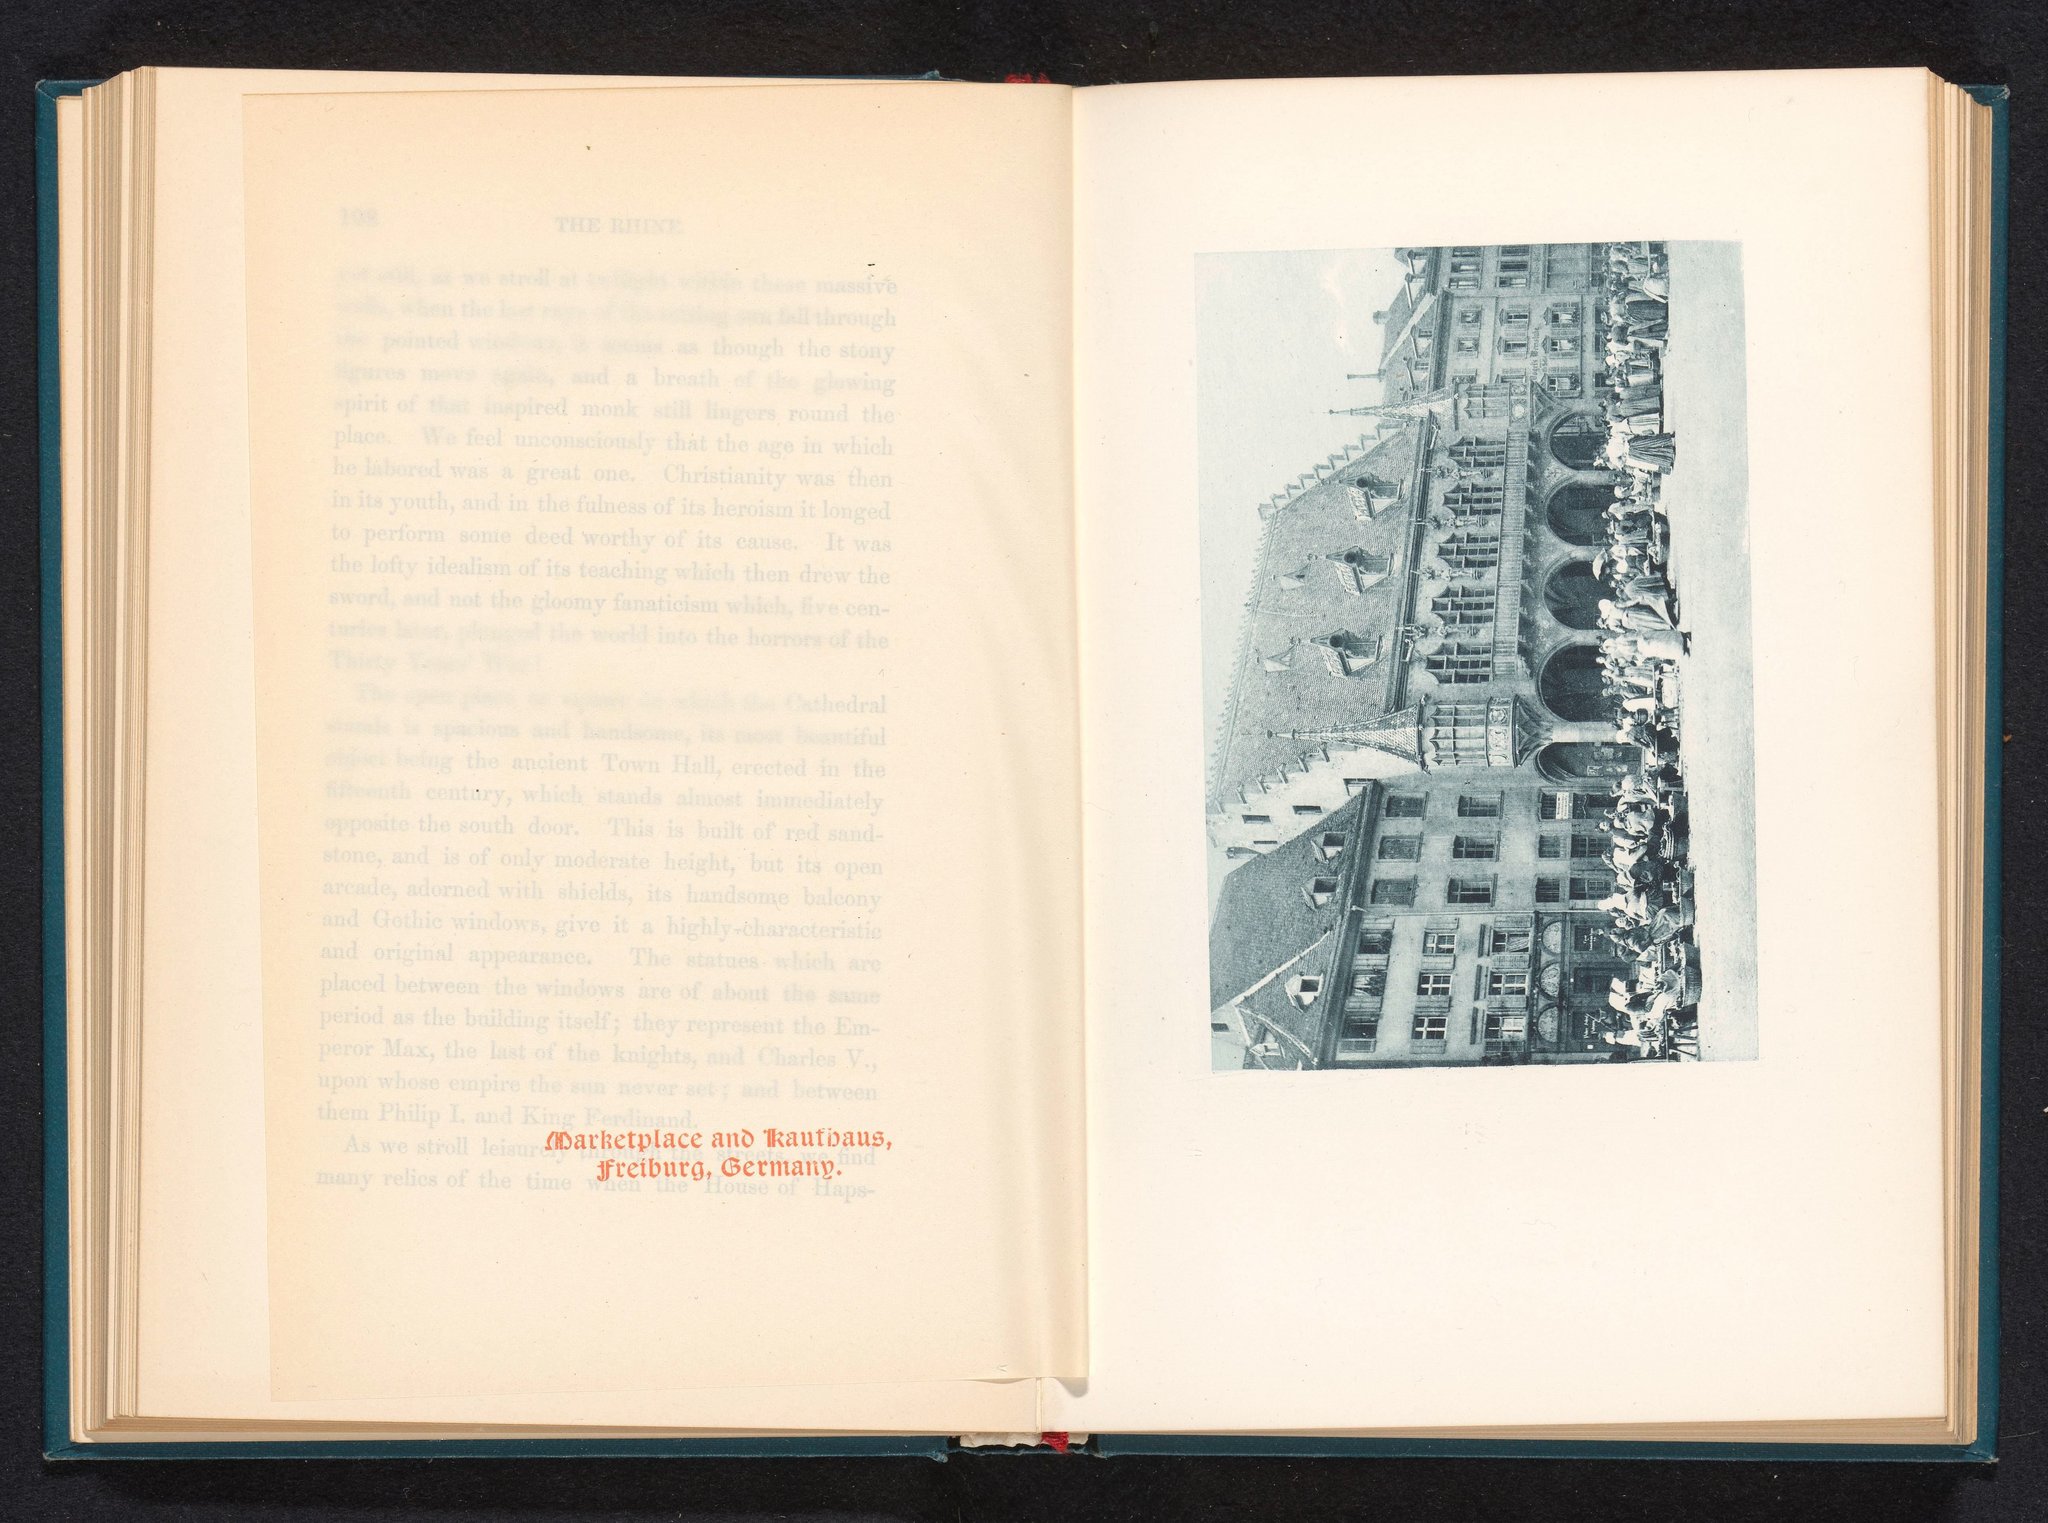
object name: page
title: Markt op de Münsterplatz te Freiburg im Breisgau, met op de achtergrond het Kaufhaus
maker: Anonymous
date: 1889-1899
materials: paper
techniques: photoaquatint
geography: münsterplatz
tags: market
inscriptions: title: ‘Marketplace and Kaufhaus, Freiburg, Germany’